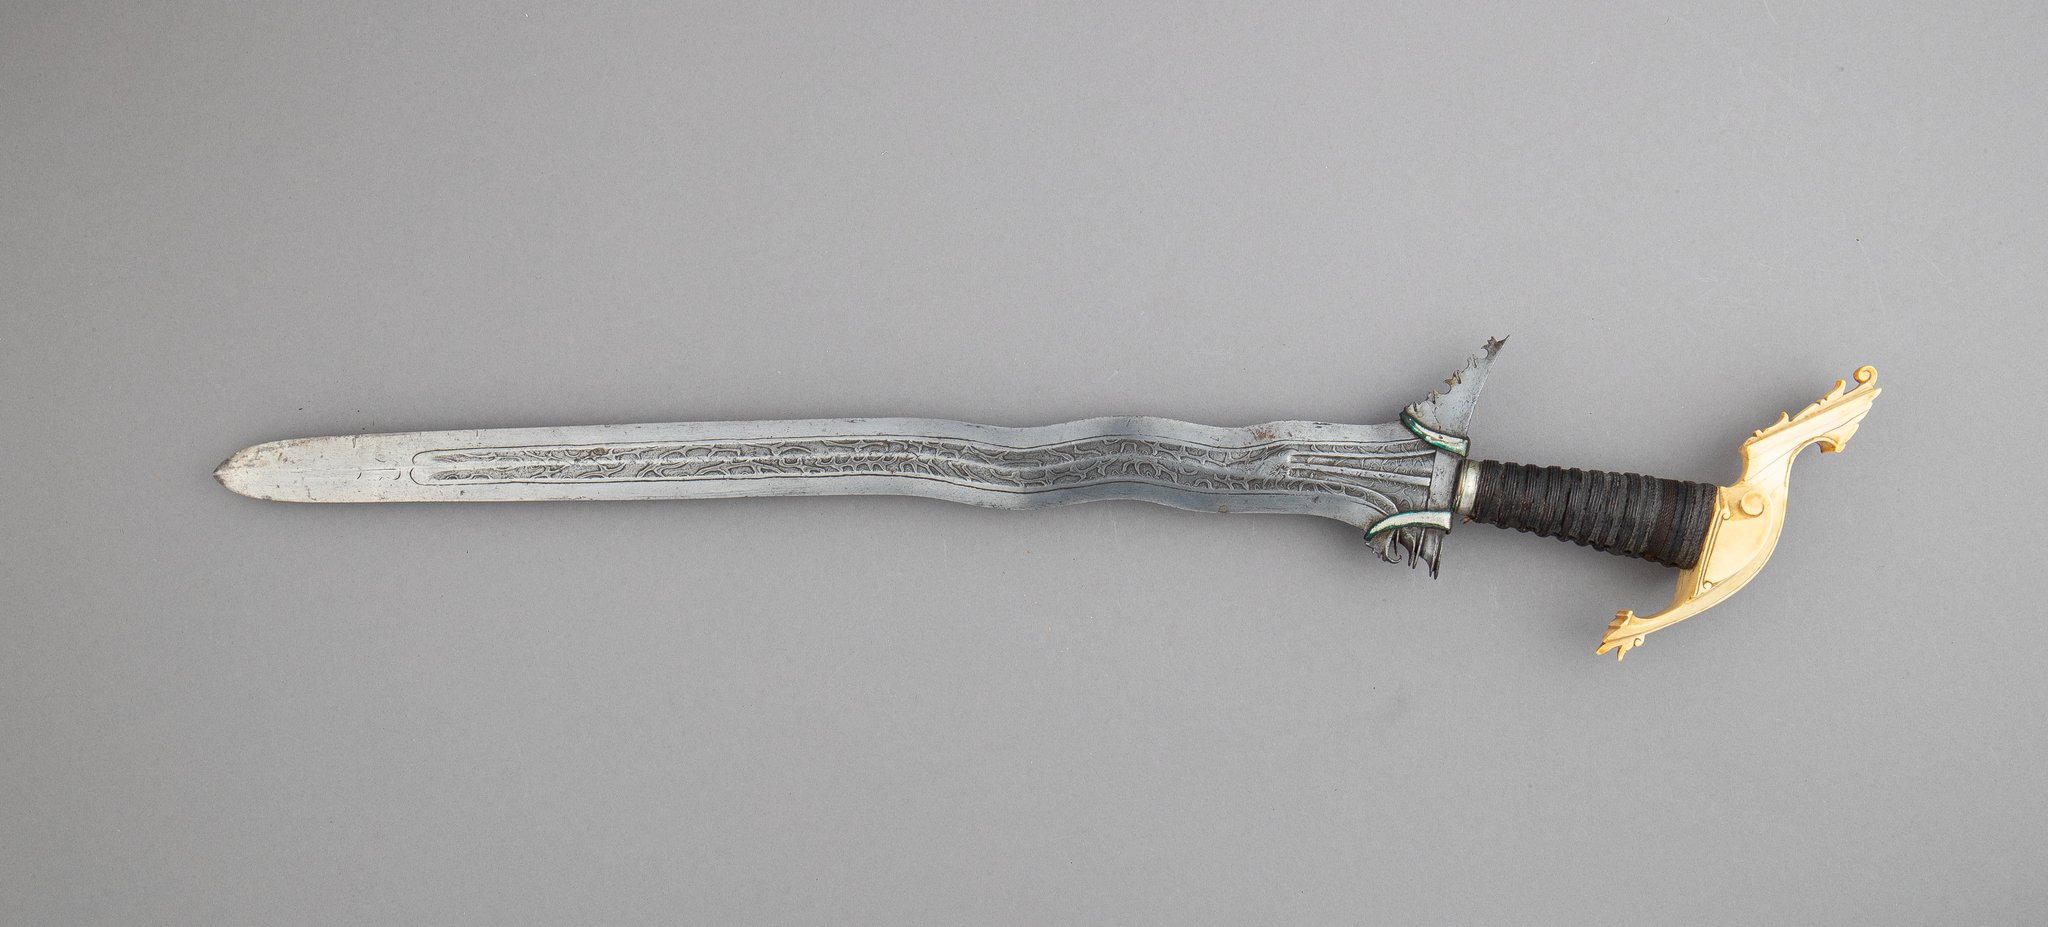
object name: kris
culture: philippine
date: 1701-1900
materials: cord, ivory, steel, wood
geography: philippines